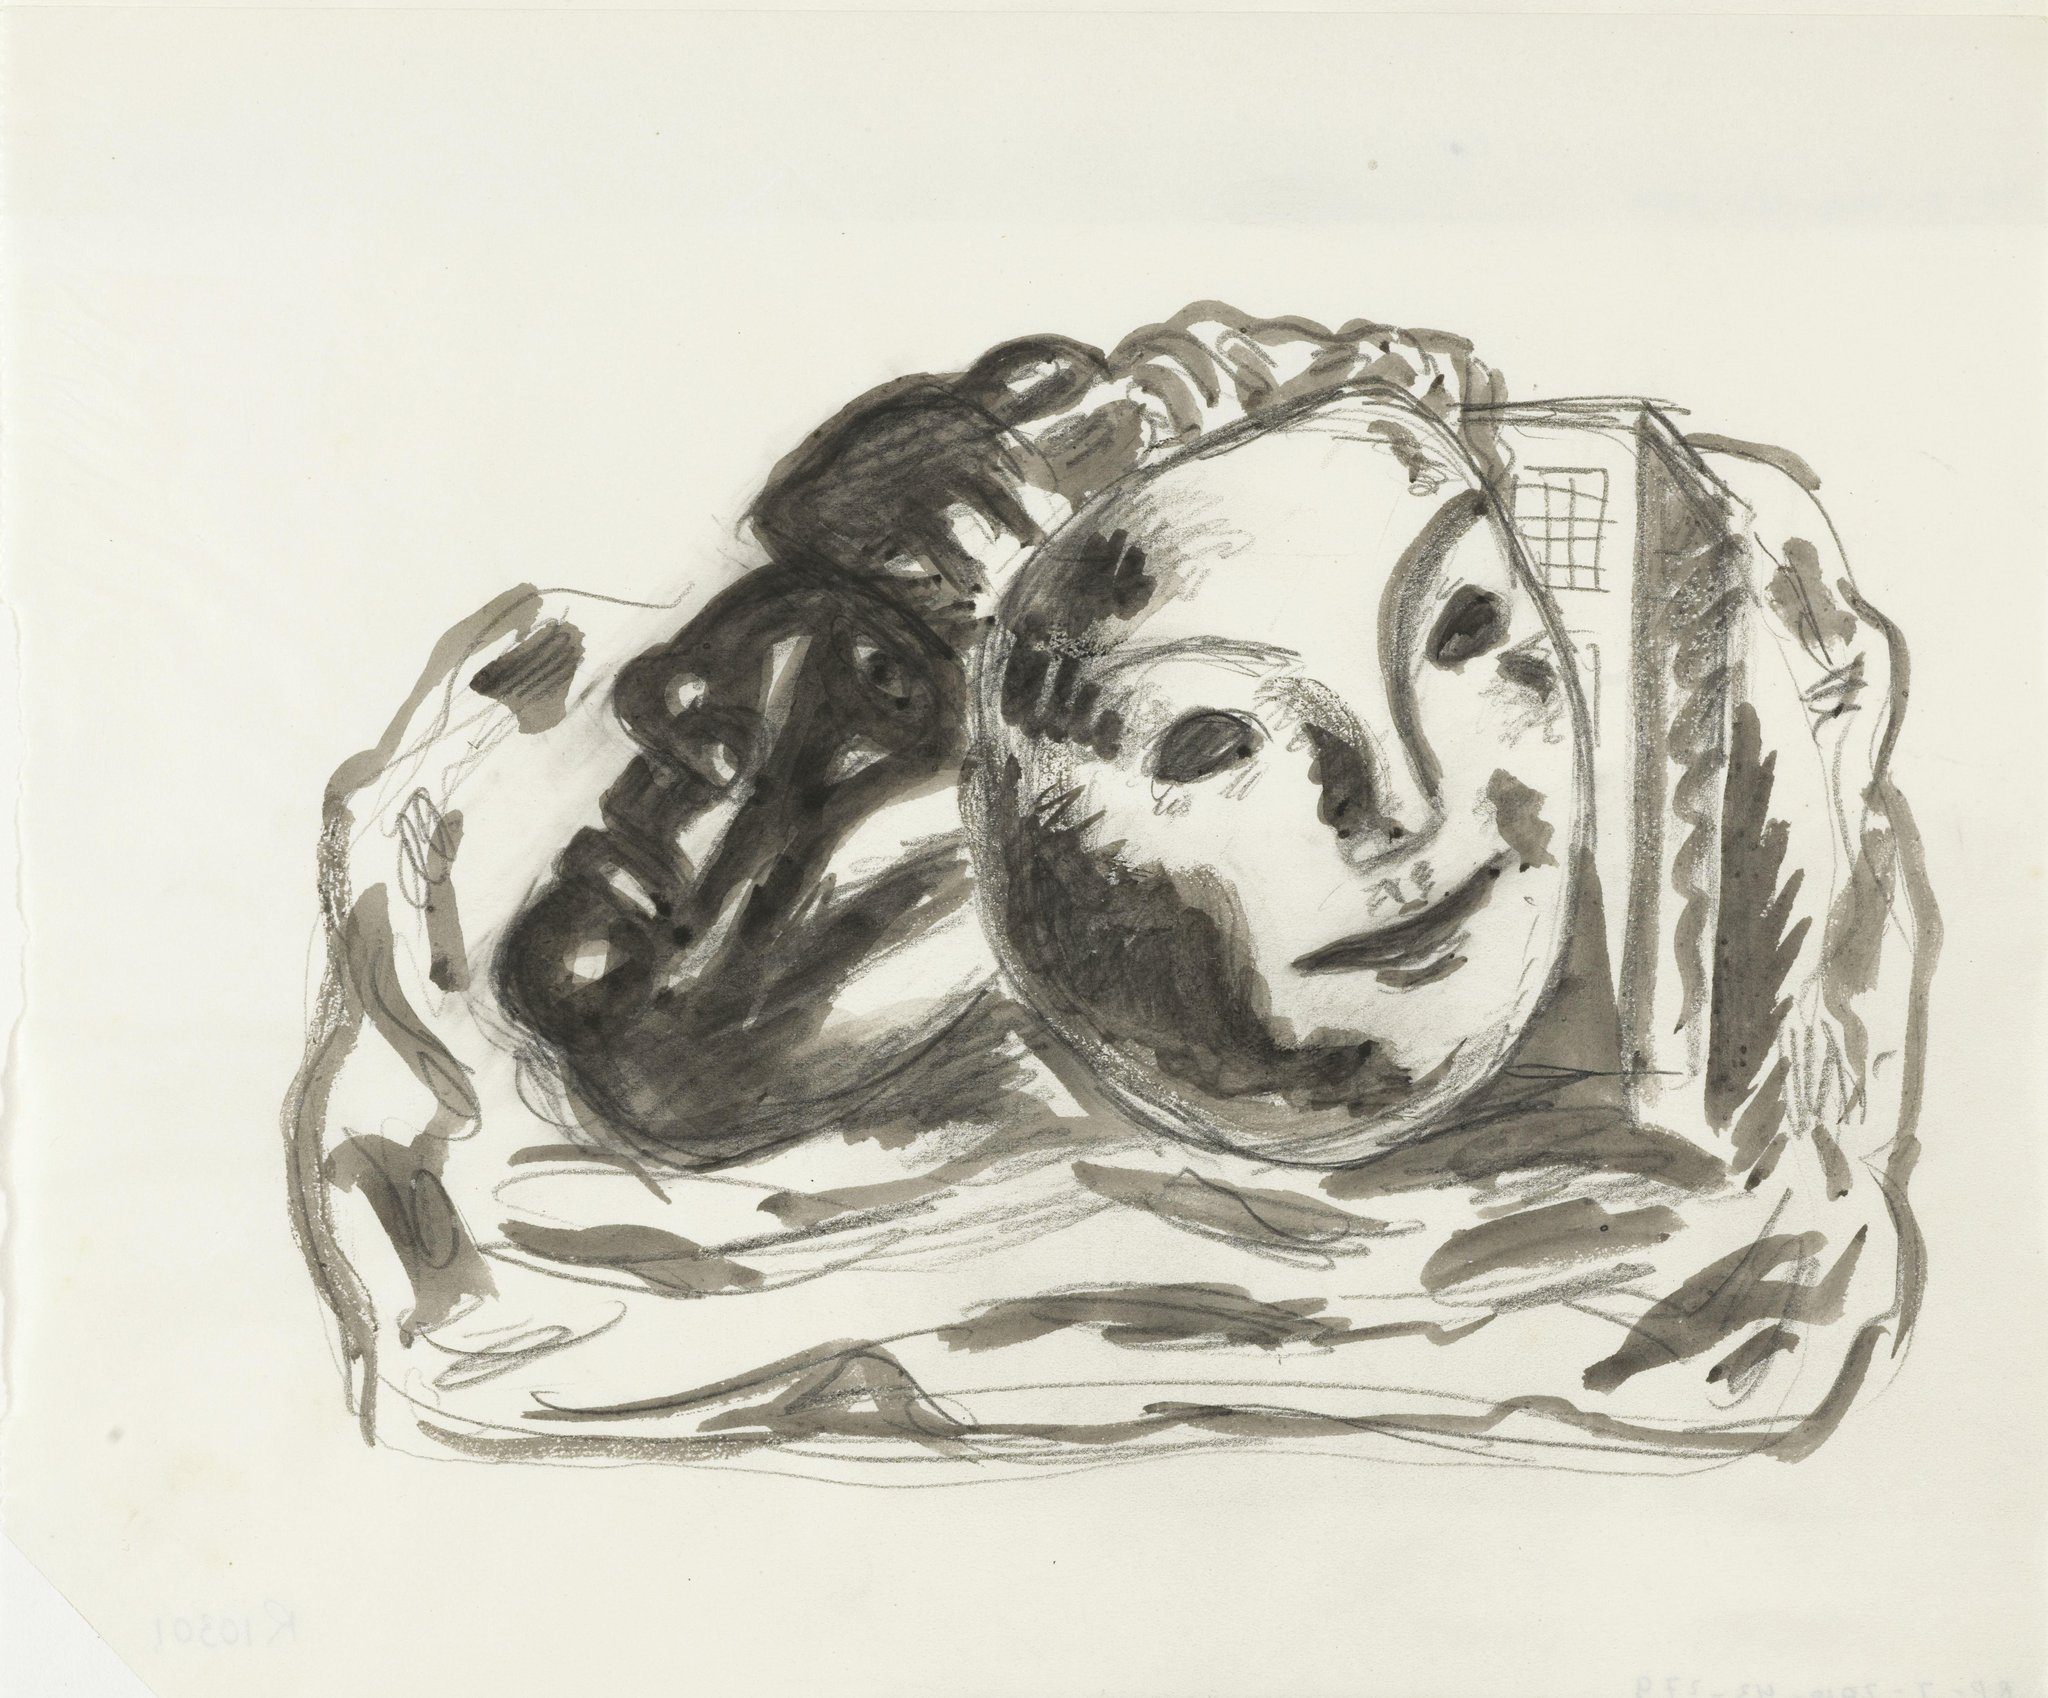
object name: drawing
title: Zonder titel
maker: leo gestel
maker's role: draughtsman, print maker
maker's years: 1881-1941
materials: ink, paper, pencil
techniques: brush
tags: mask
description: Twee maskers voor gebouw en rotsen, de ondertekening in potlood zichtbaar.